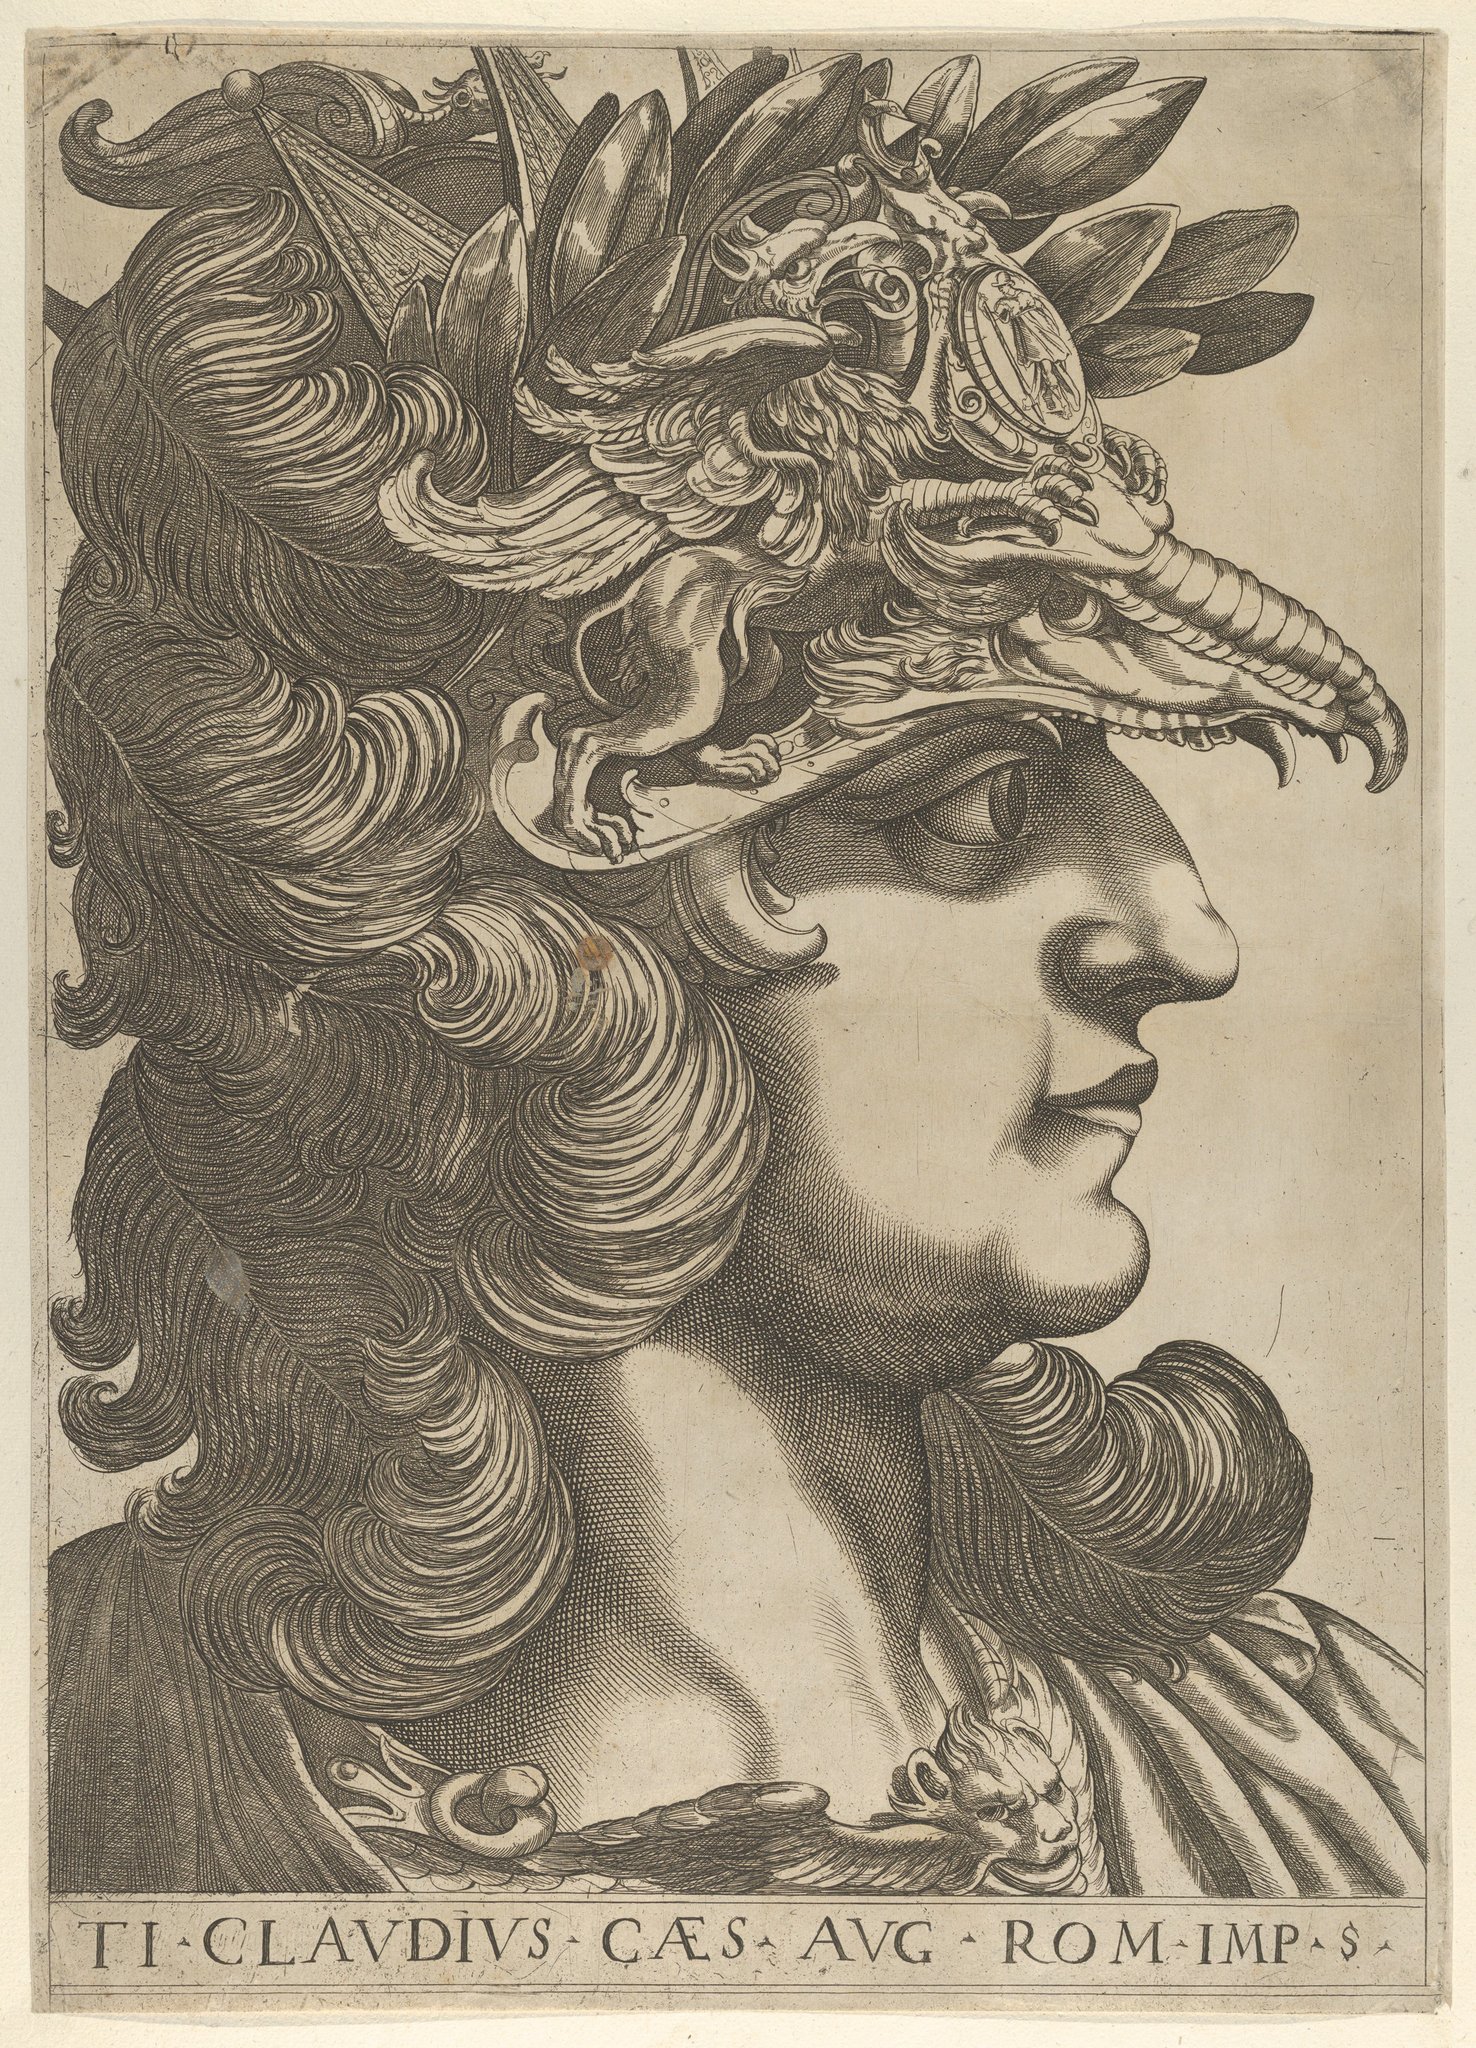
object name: print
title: Plate 5: Tiberius Claudius in profile to the right, from "The Twelve Caesars"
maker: Anonymous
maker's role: artist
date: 1610-1640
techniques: engraving, etching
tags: helmets,emperors,men